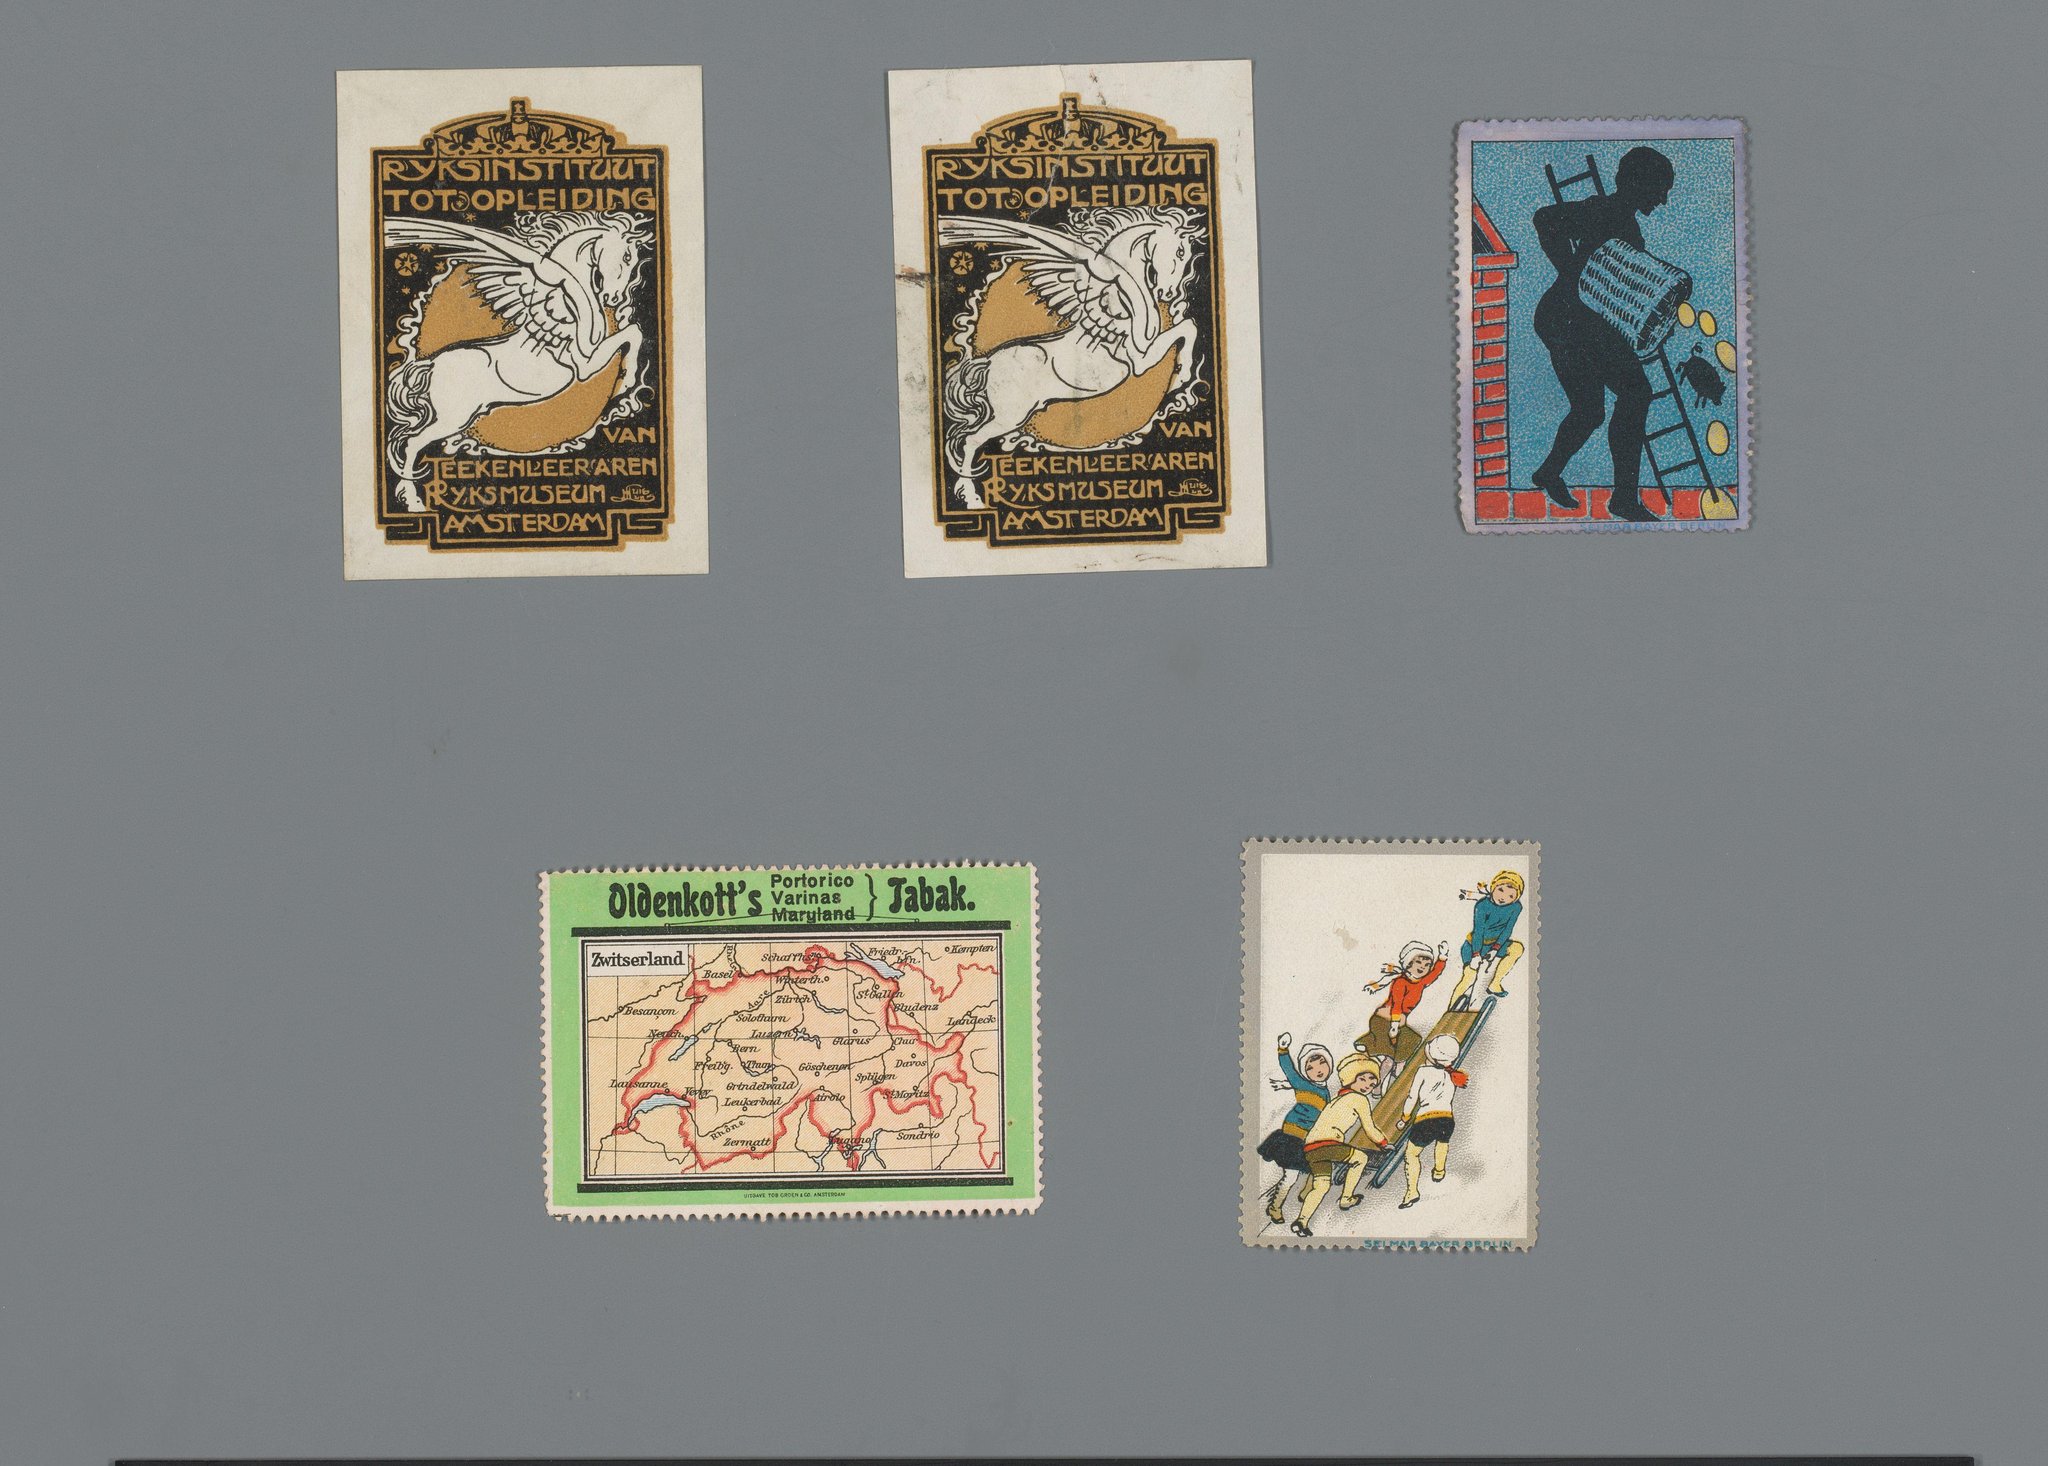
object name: sluitzegel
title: Nederlandse (sluit)zegels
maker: reinier willem petrus de vries (1874-1953)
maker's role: draughtsman, print maker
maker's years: 1874-1953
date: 1897-1932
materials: paper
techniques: printing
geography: netherlands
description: Verzameling van 196 (sluit)zegels afkomstig uit Nederland. De verzameling is samengesteld door R.W.P. de Vries Jr.